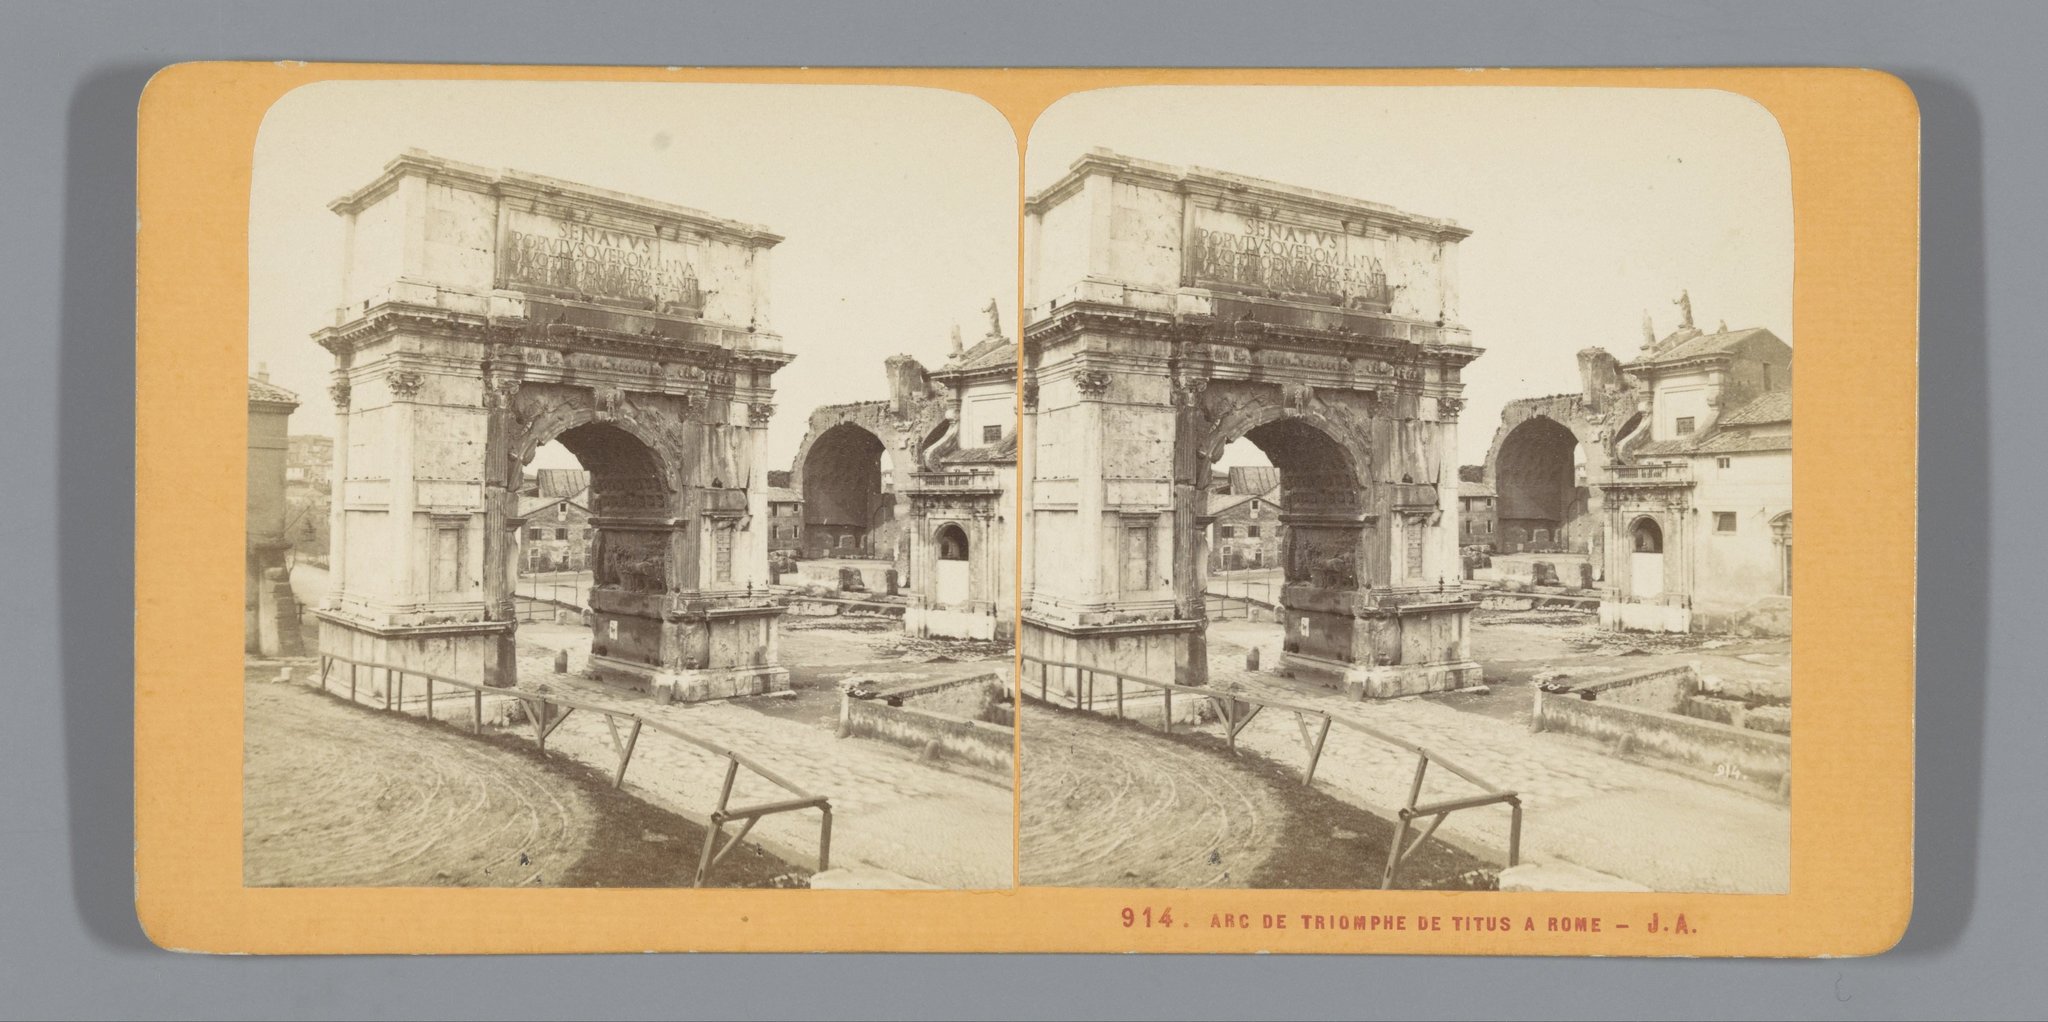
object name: stereograph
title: Arc de Triomphe de Titus a Rome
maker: jean andrieu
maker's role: fotograaf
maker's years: 1816-1872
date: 1862-1876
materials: cardboard, paper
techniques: albumen print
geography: rome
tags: triumphal arch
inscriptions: number: ‘914’